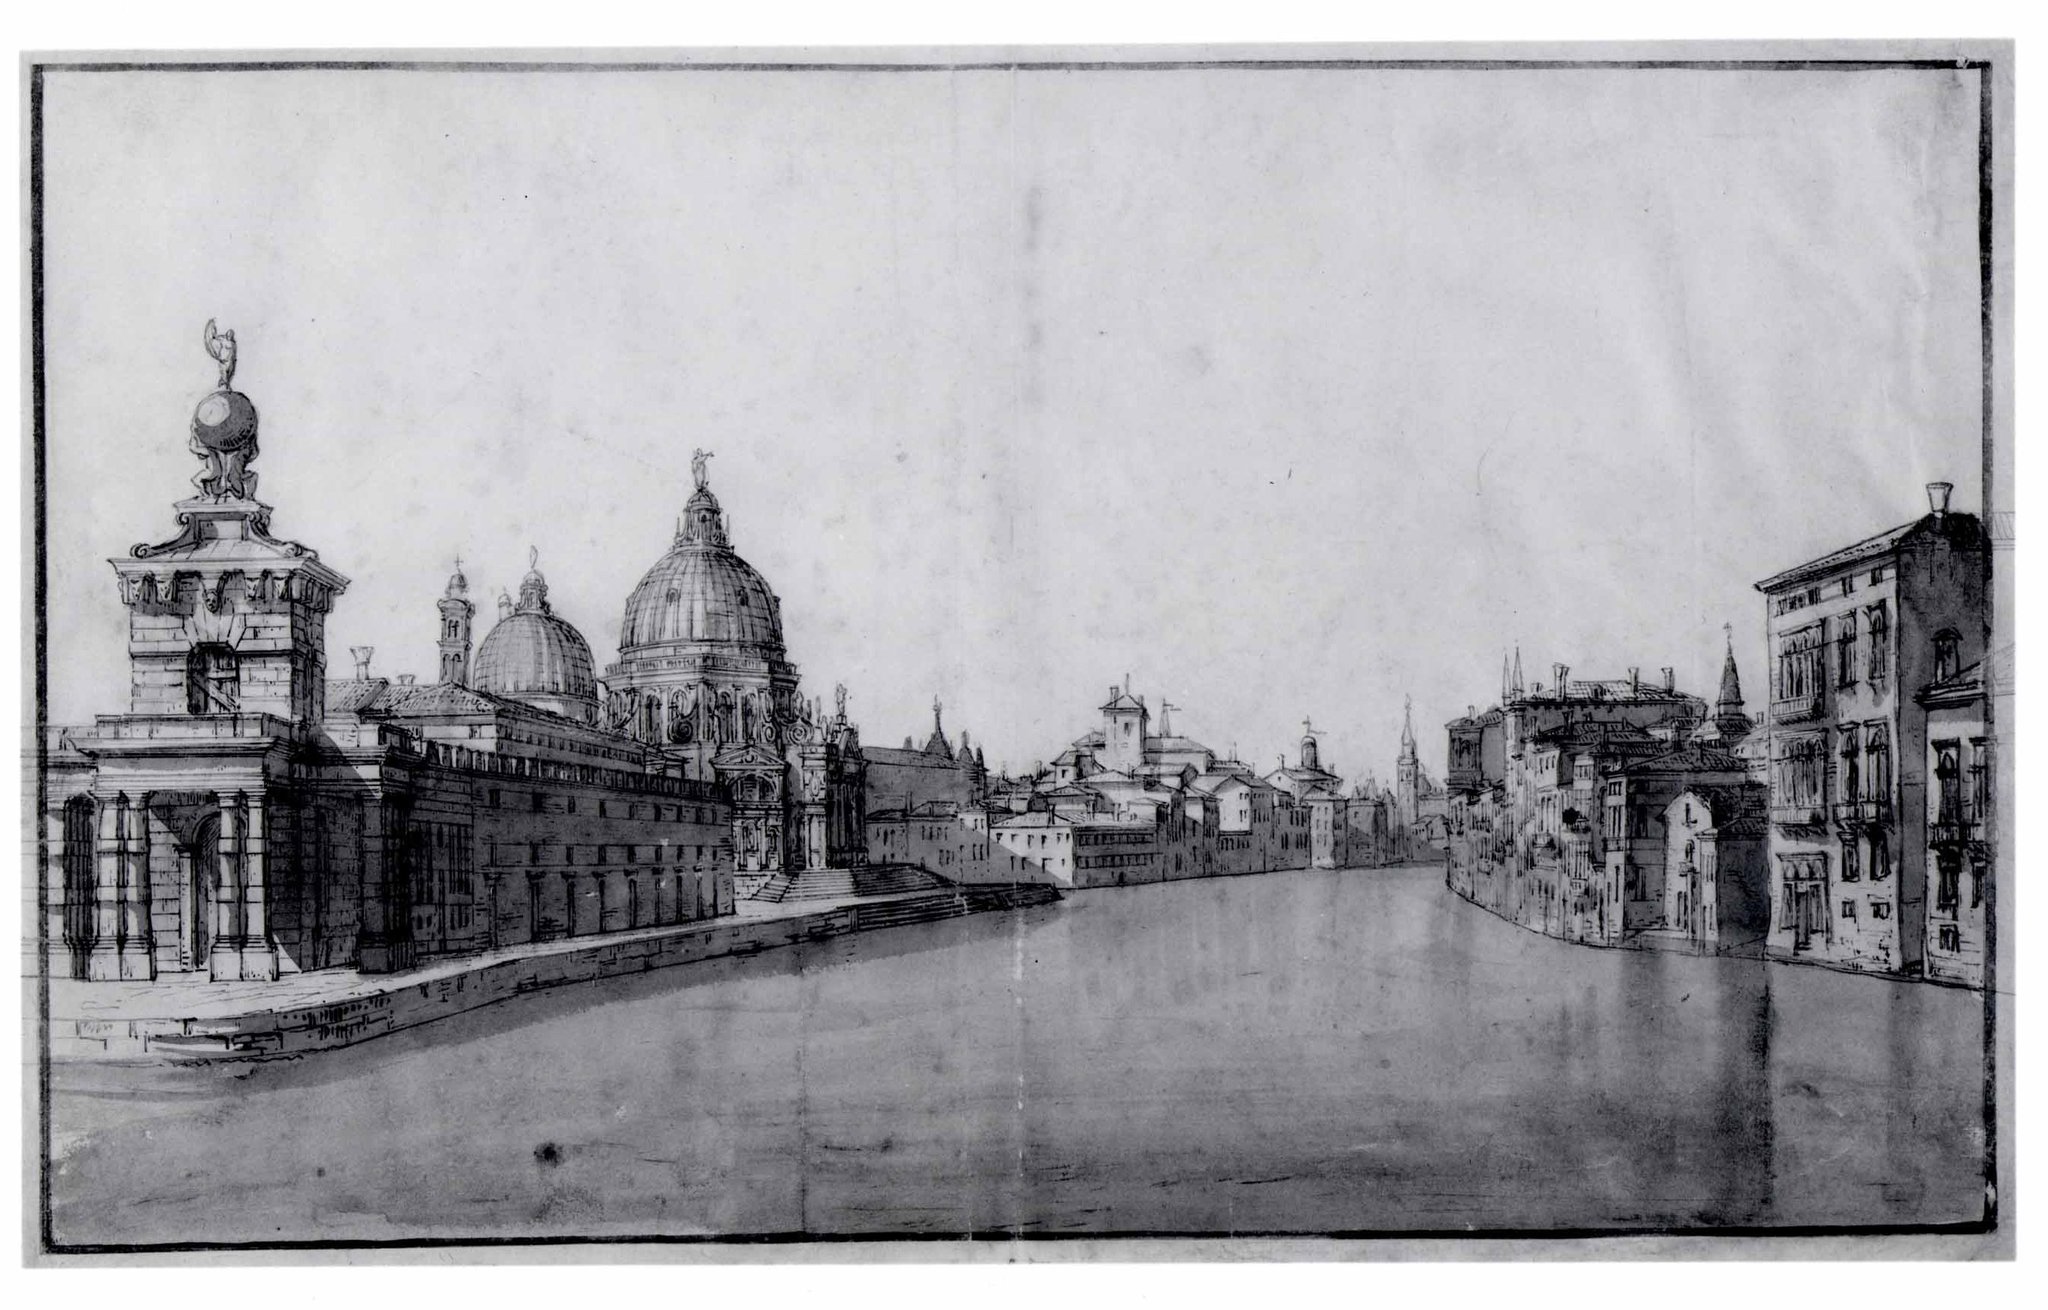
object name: drawing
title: The Entrance to the Grand Canal, with the Dogana da Mar and Santa Maria della Salute on the Left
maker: bernardo bellotto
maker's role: artist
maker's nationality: italian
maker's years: 1722-1780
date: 1736-1737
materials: ink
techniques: pen, wash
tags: buildings,canals